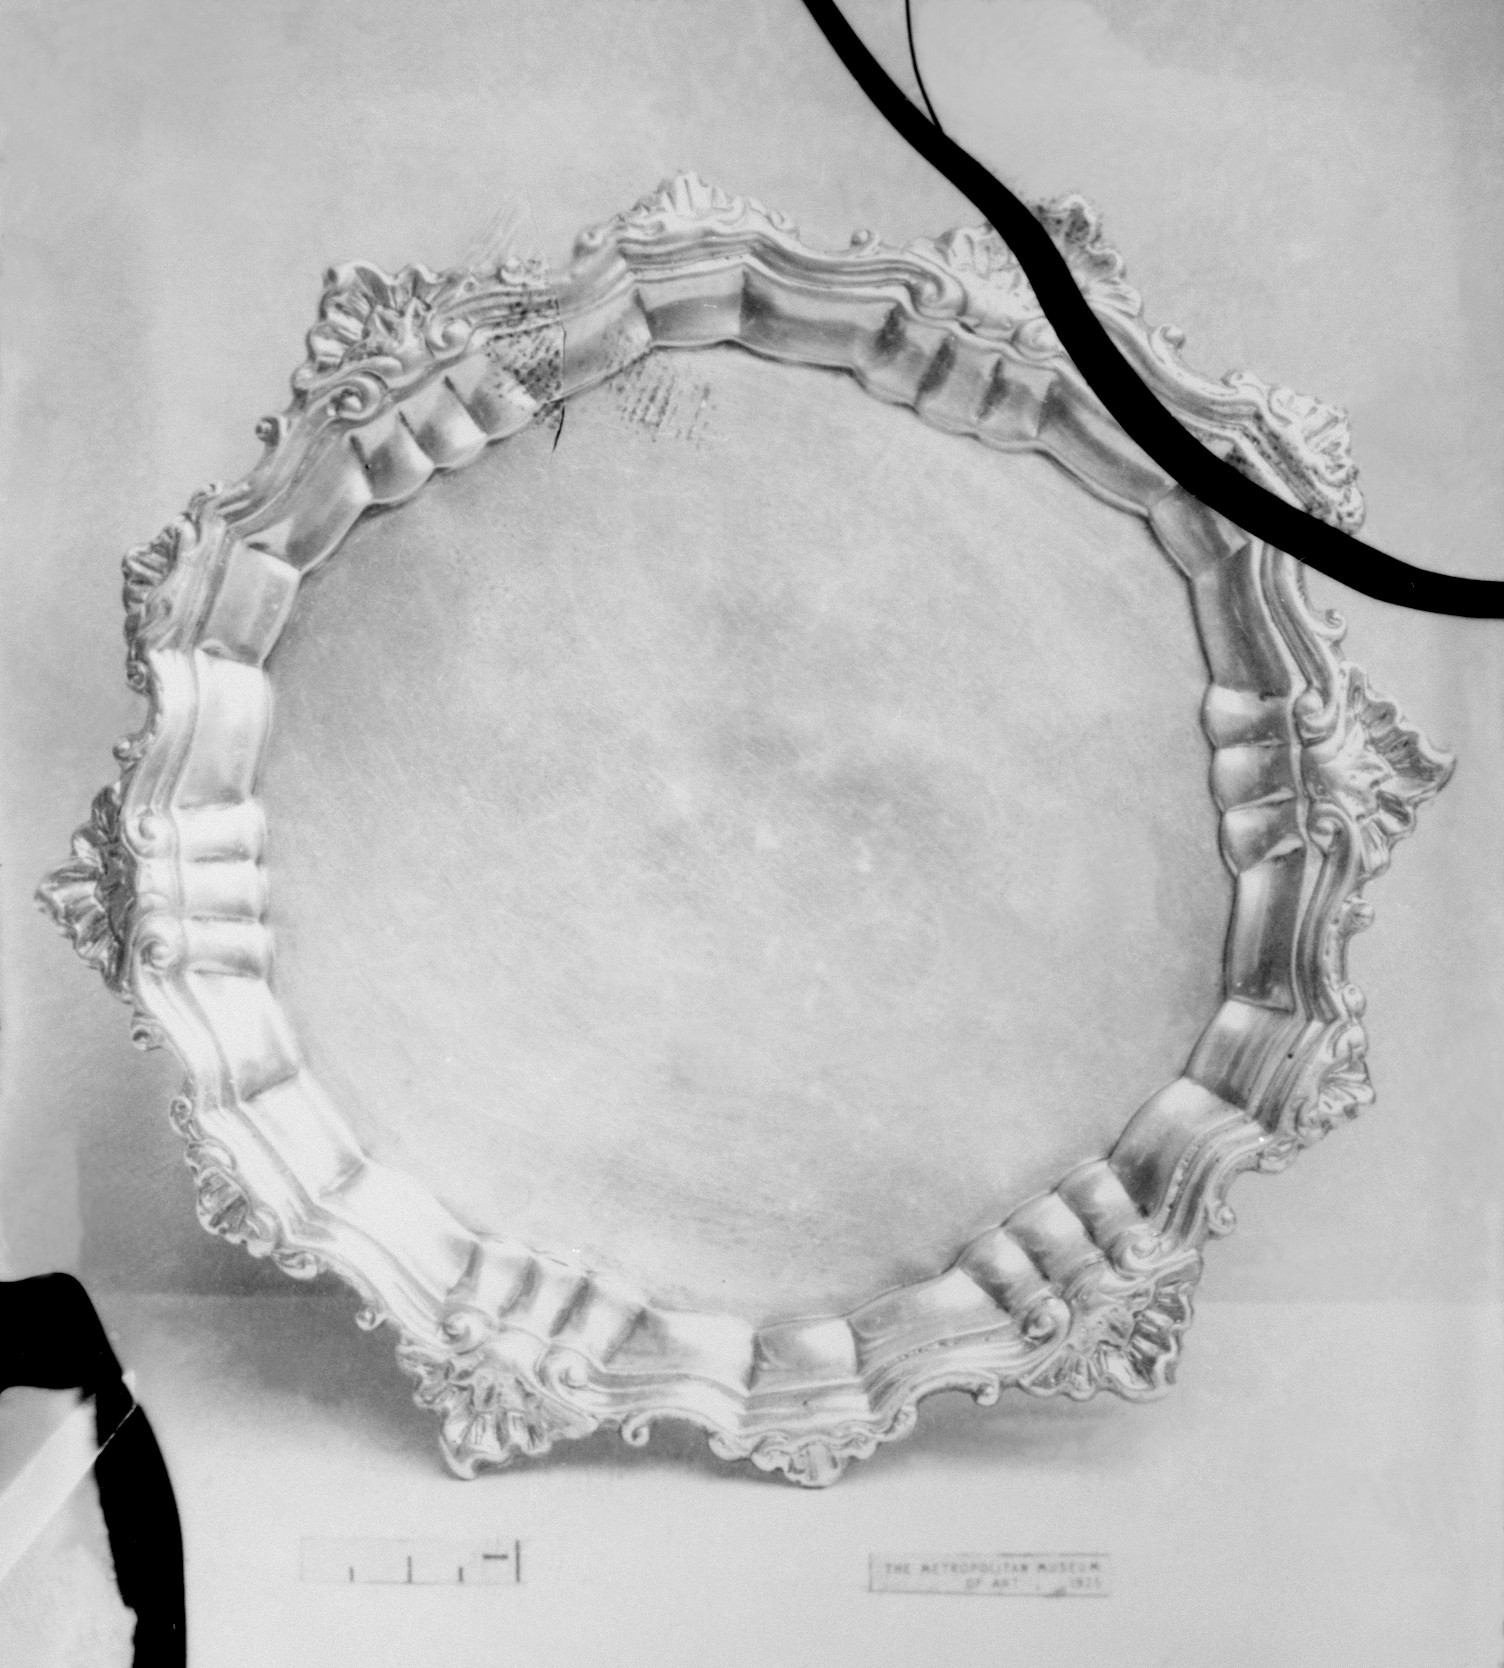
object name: salver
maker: william homer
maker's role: maker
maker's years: 1673-1773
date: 1765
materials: silver